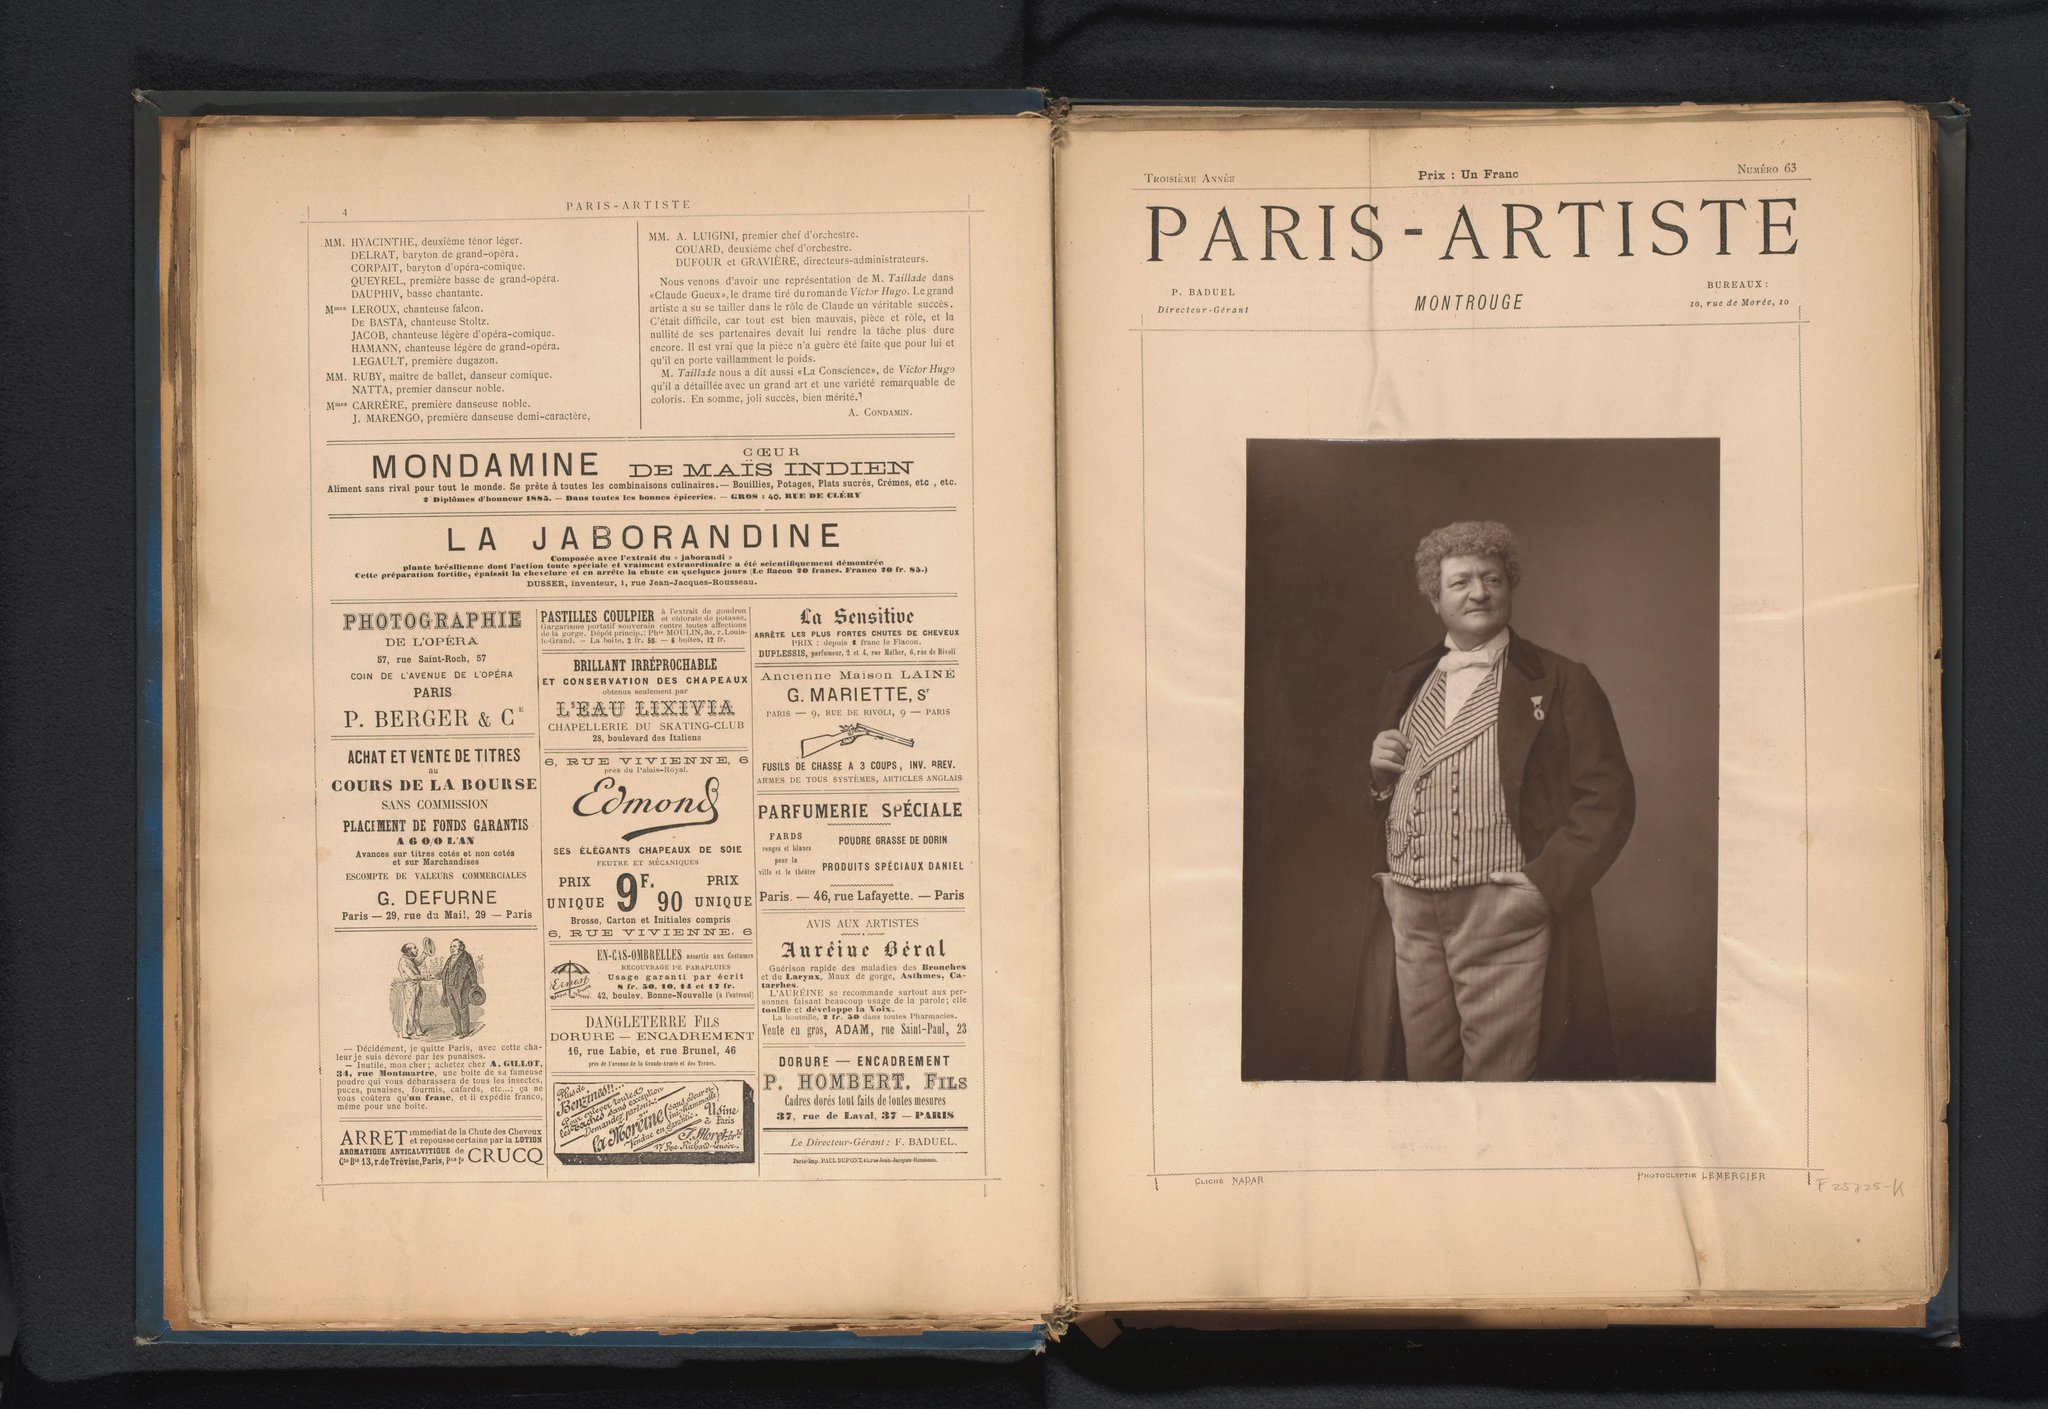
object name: page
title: Portret van een onbekende man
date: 1880-1885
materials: paper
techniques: woodburytype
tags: historical persons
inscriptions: name: ‘Montrouge’